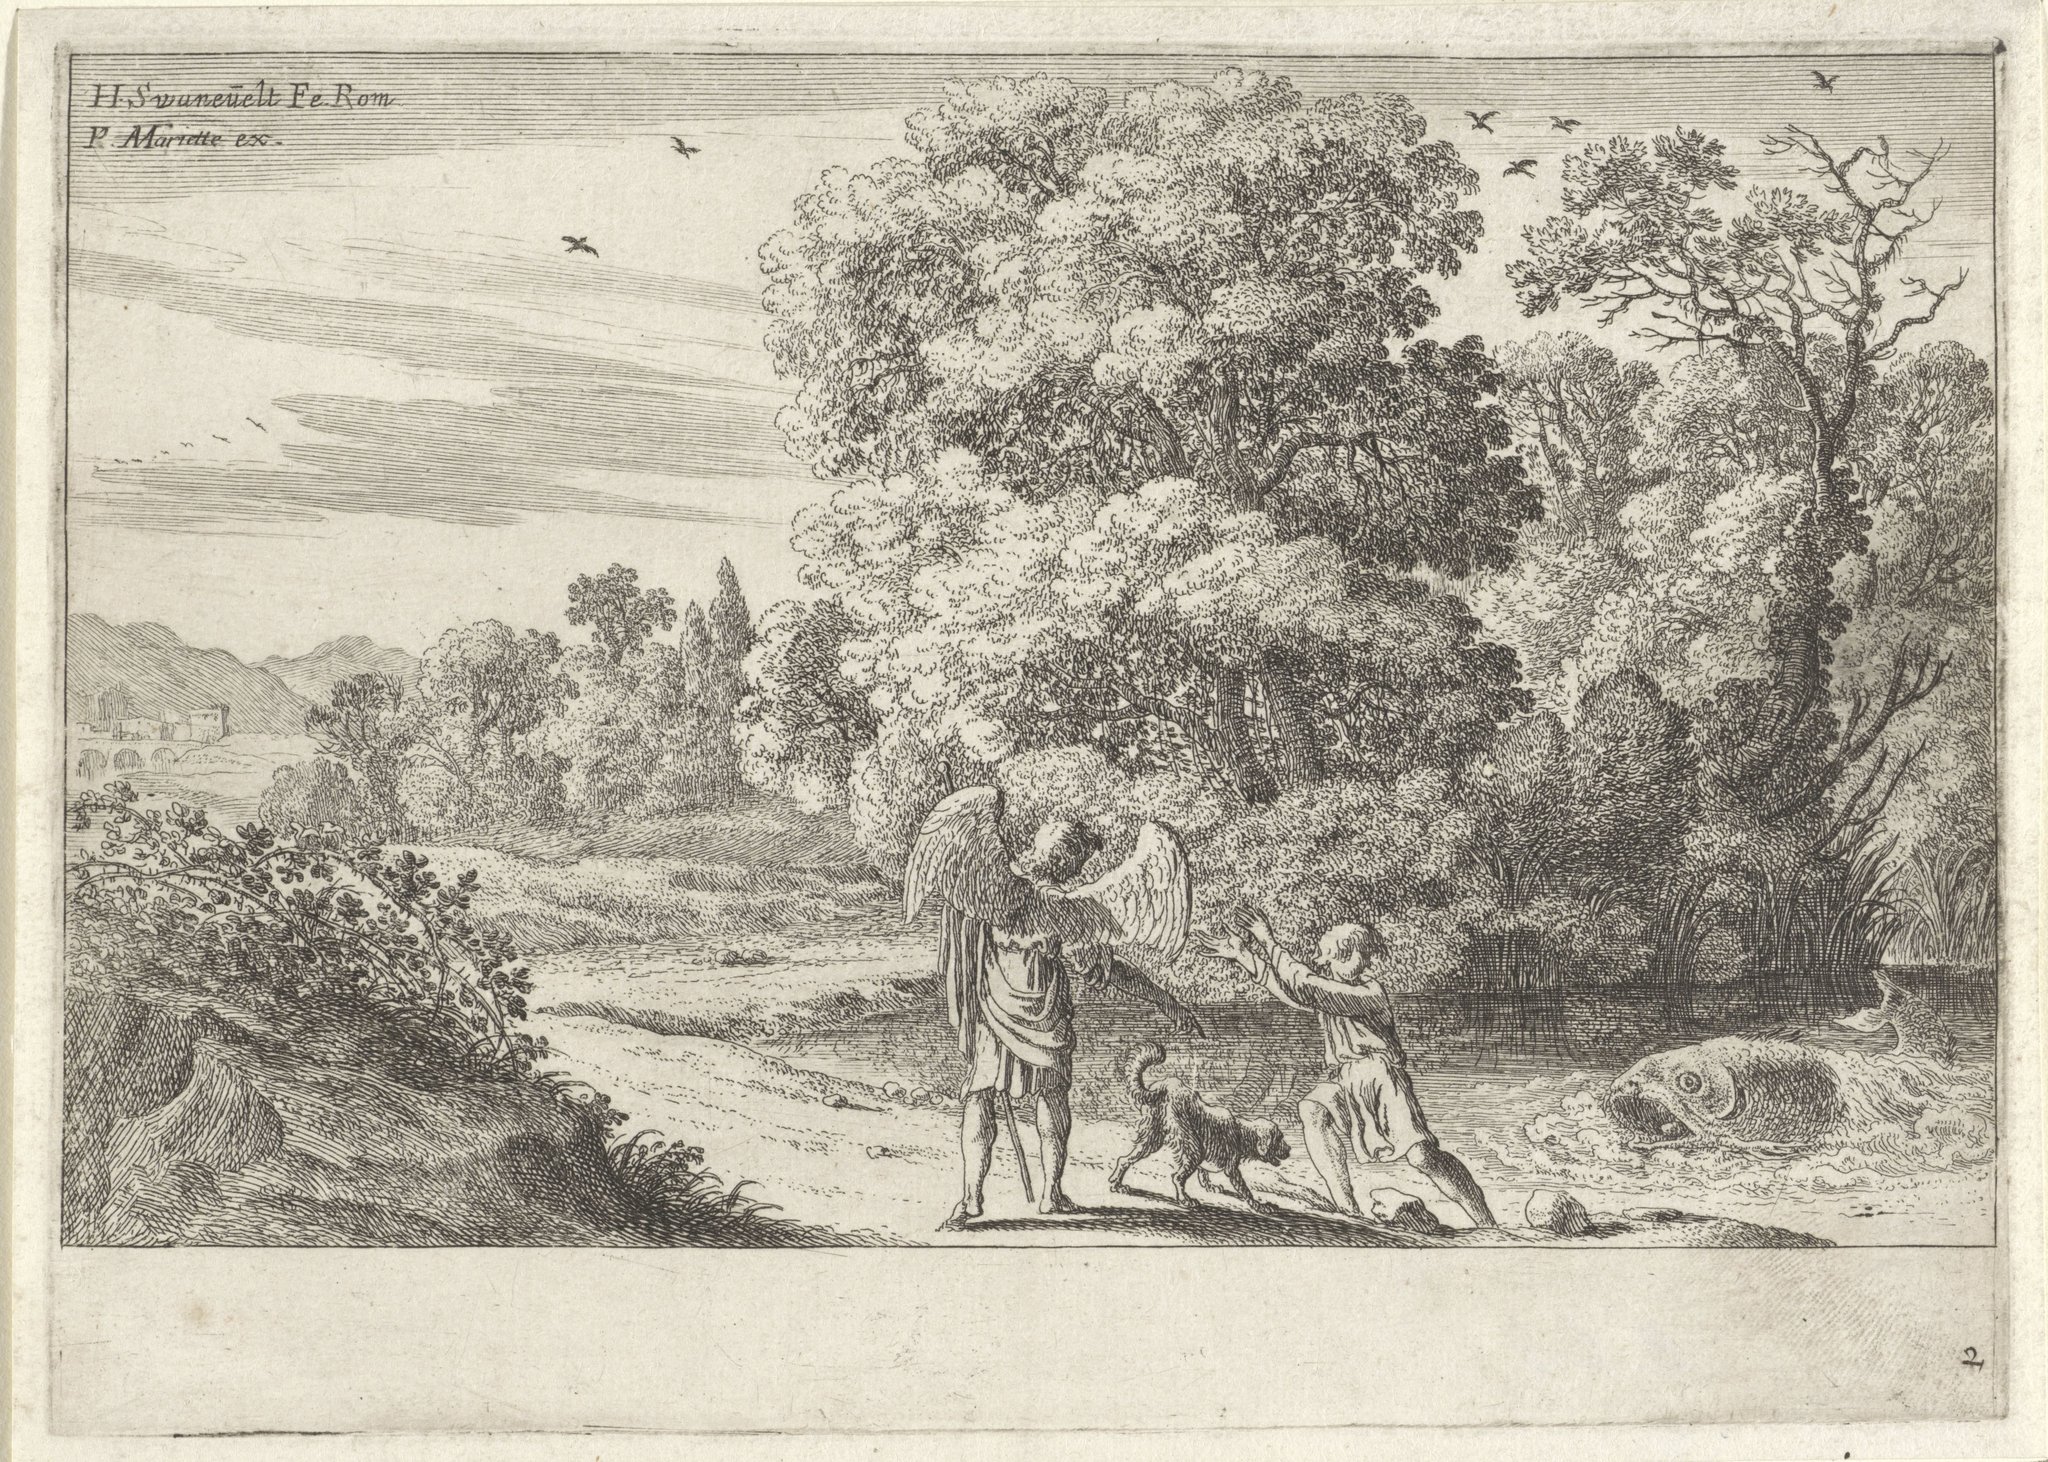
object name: print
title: Oudtestamentische voorstellingen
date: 1629-1641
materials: paper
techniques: etching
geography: paris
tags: a large fish appears while tobias is washing his feet; he is frightened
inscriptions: collector's mark: ‘KONING: BIBLIO:’ Lugt 240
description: In een bebost, heuvelachtig landschap zijn Tobias, een hond en de engel Rafaël op de voorgrond bij de rivier de Tigris weergegeven. Tobias komt met opgeheven armen uit het water en kijkt verschrikt achterom naar de grote vis die naar de oppervlakte is gekomen.